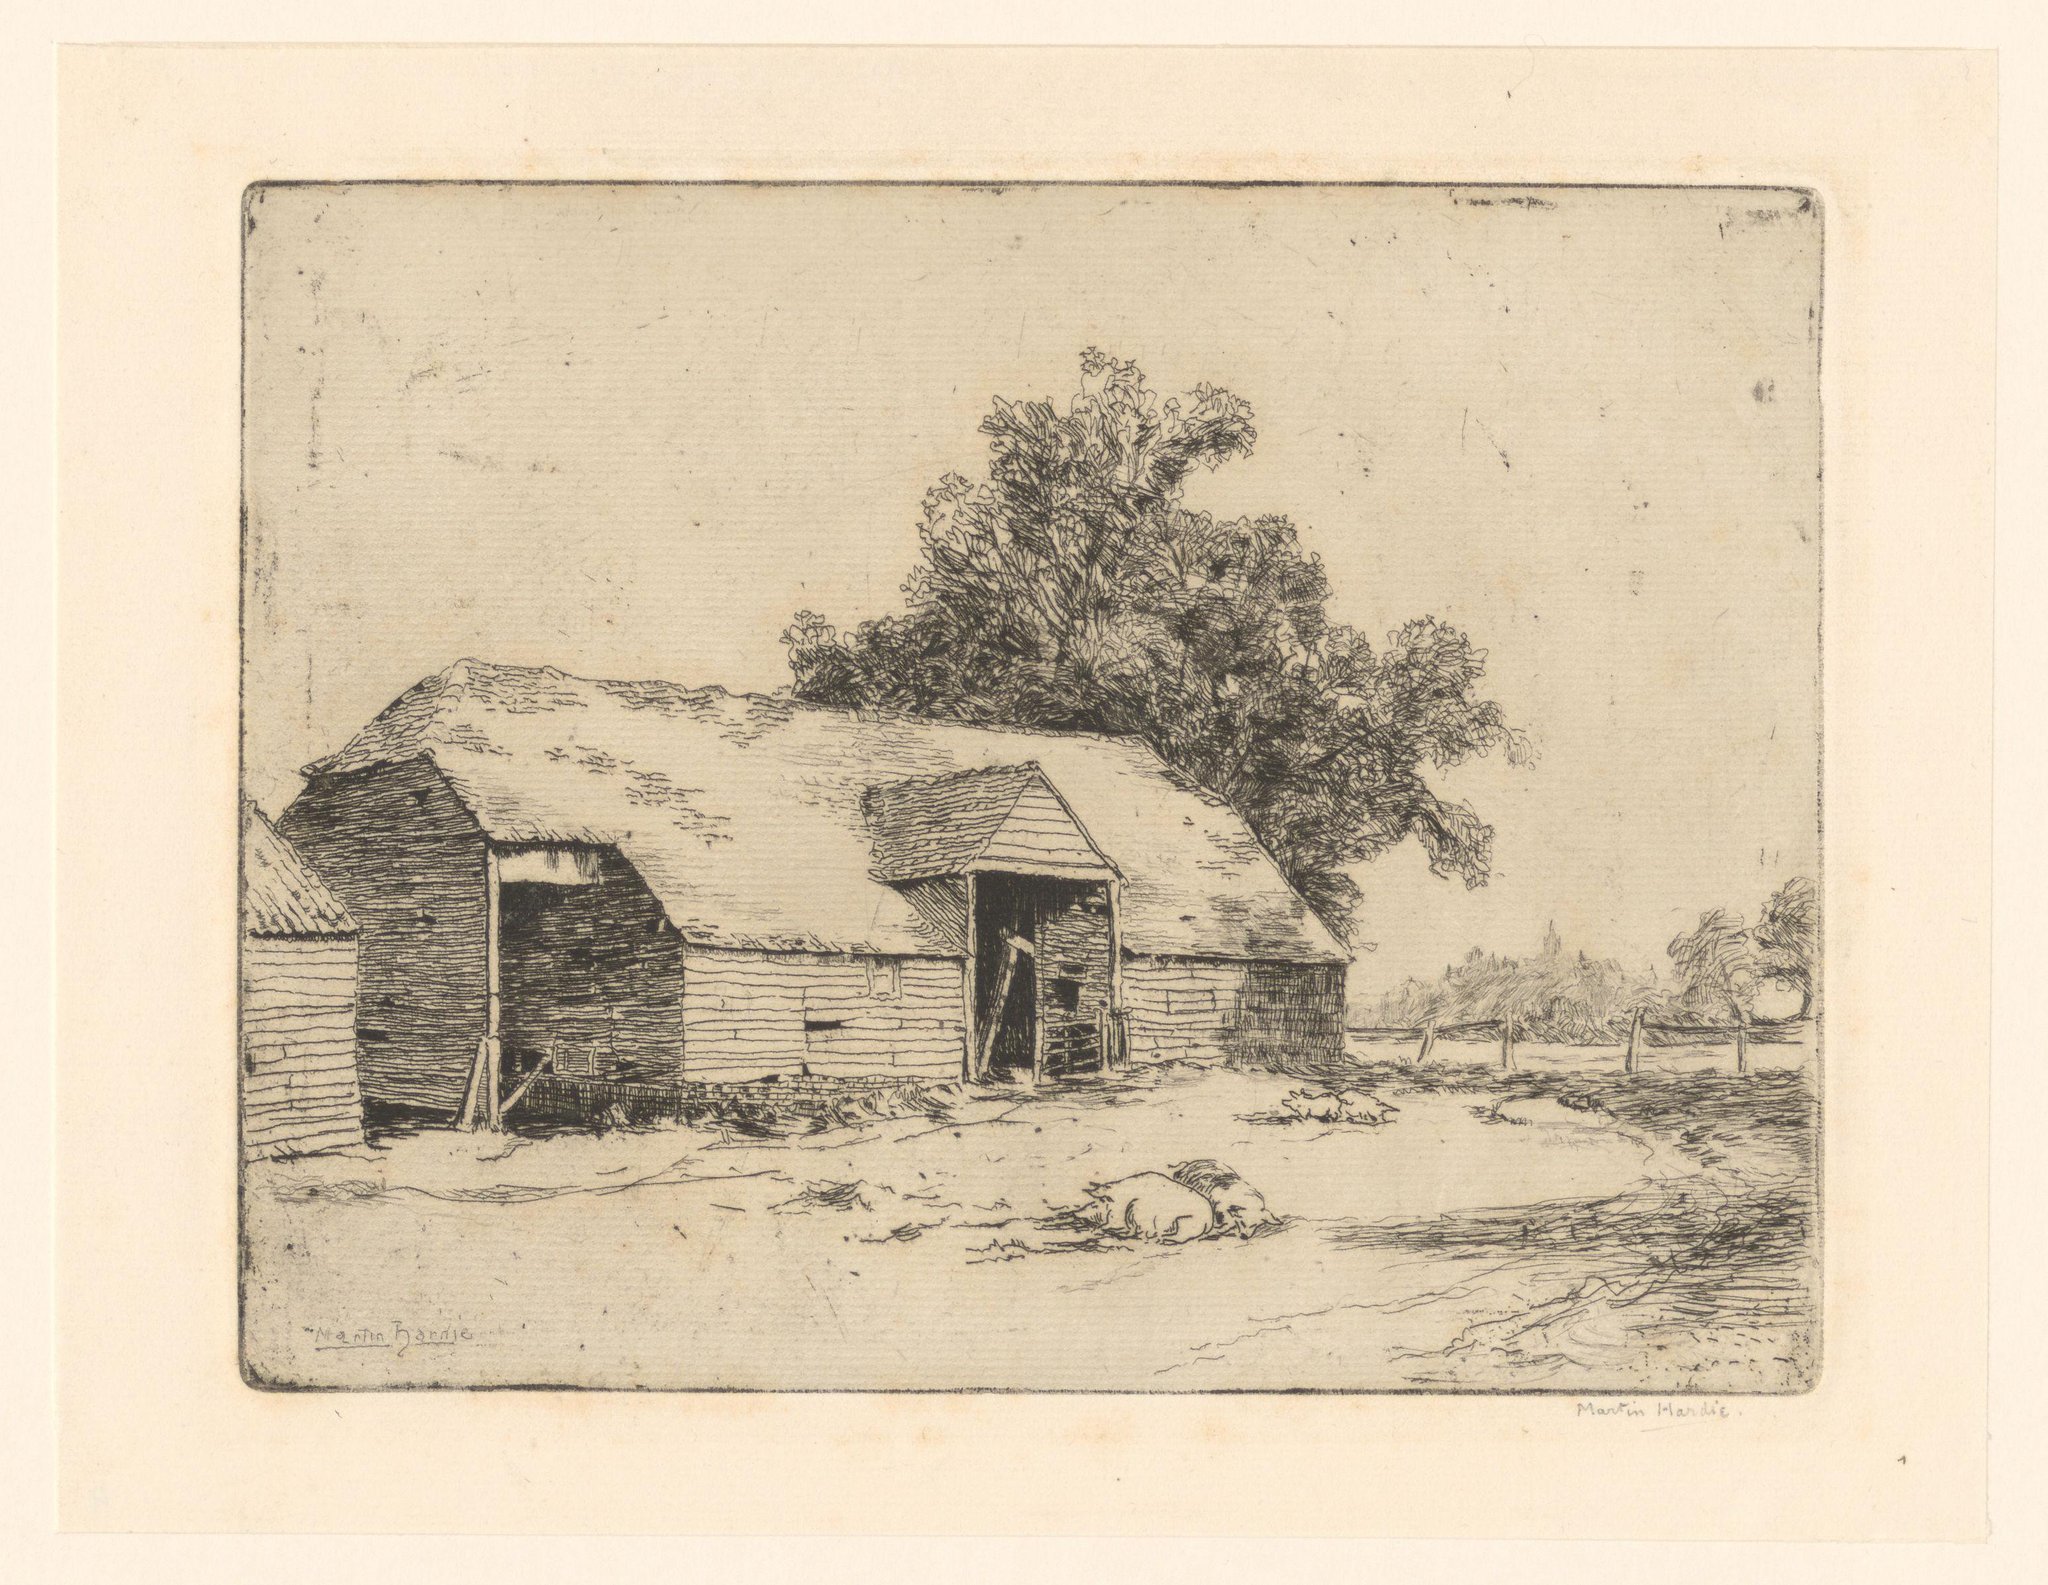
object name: print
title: Gezicht op een schuur met varkens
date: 1906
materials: paper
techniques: etching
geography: greenford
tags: barn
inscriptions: collector's mark: Lugt 2760, annotation: ‘Martin Hardie’, collector's mark: Lugt 2228